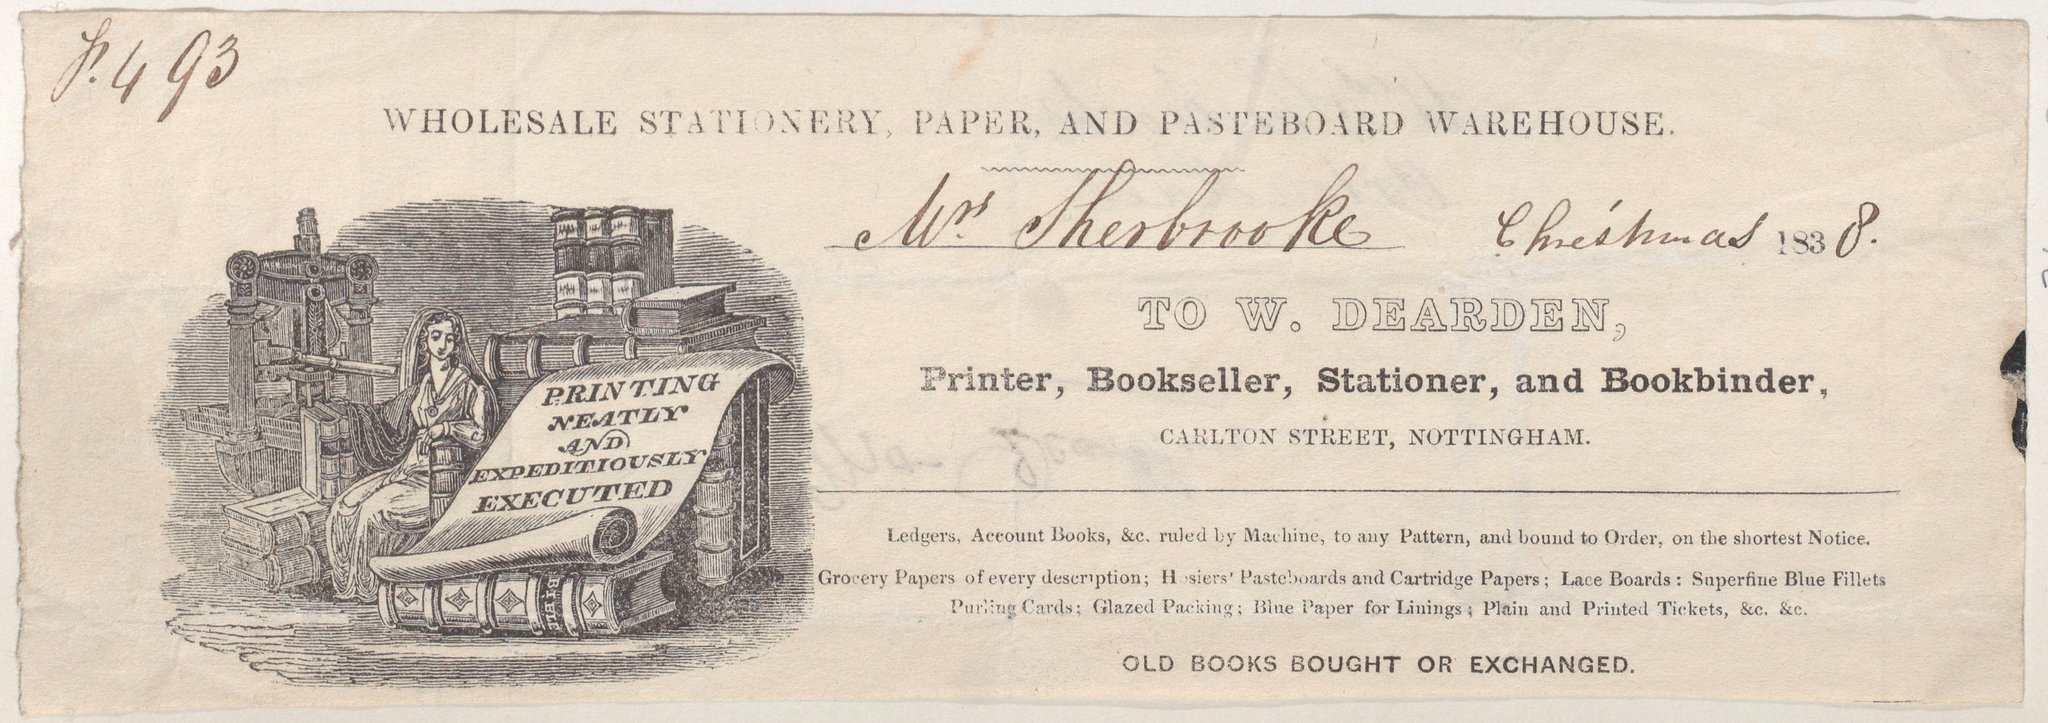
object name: print, trade card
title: Trade Card for W. Dearden, Printer, Bookseller, Stationer, and Bookbinder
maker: anonymous, british, 19th century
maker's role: artist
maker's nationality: british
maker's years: 1800-1900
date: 1801-1900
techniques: engraving